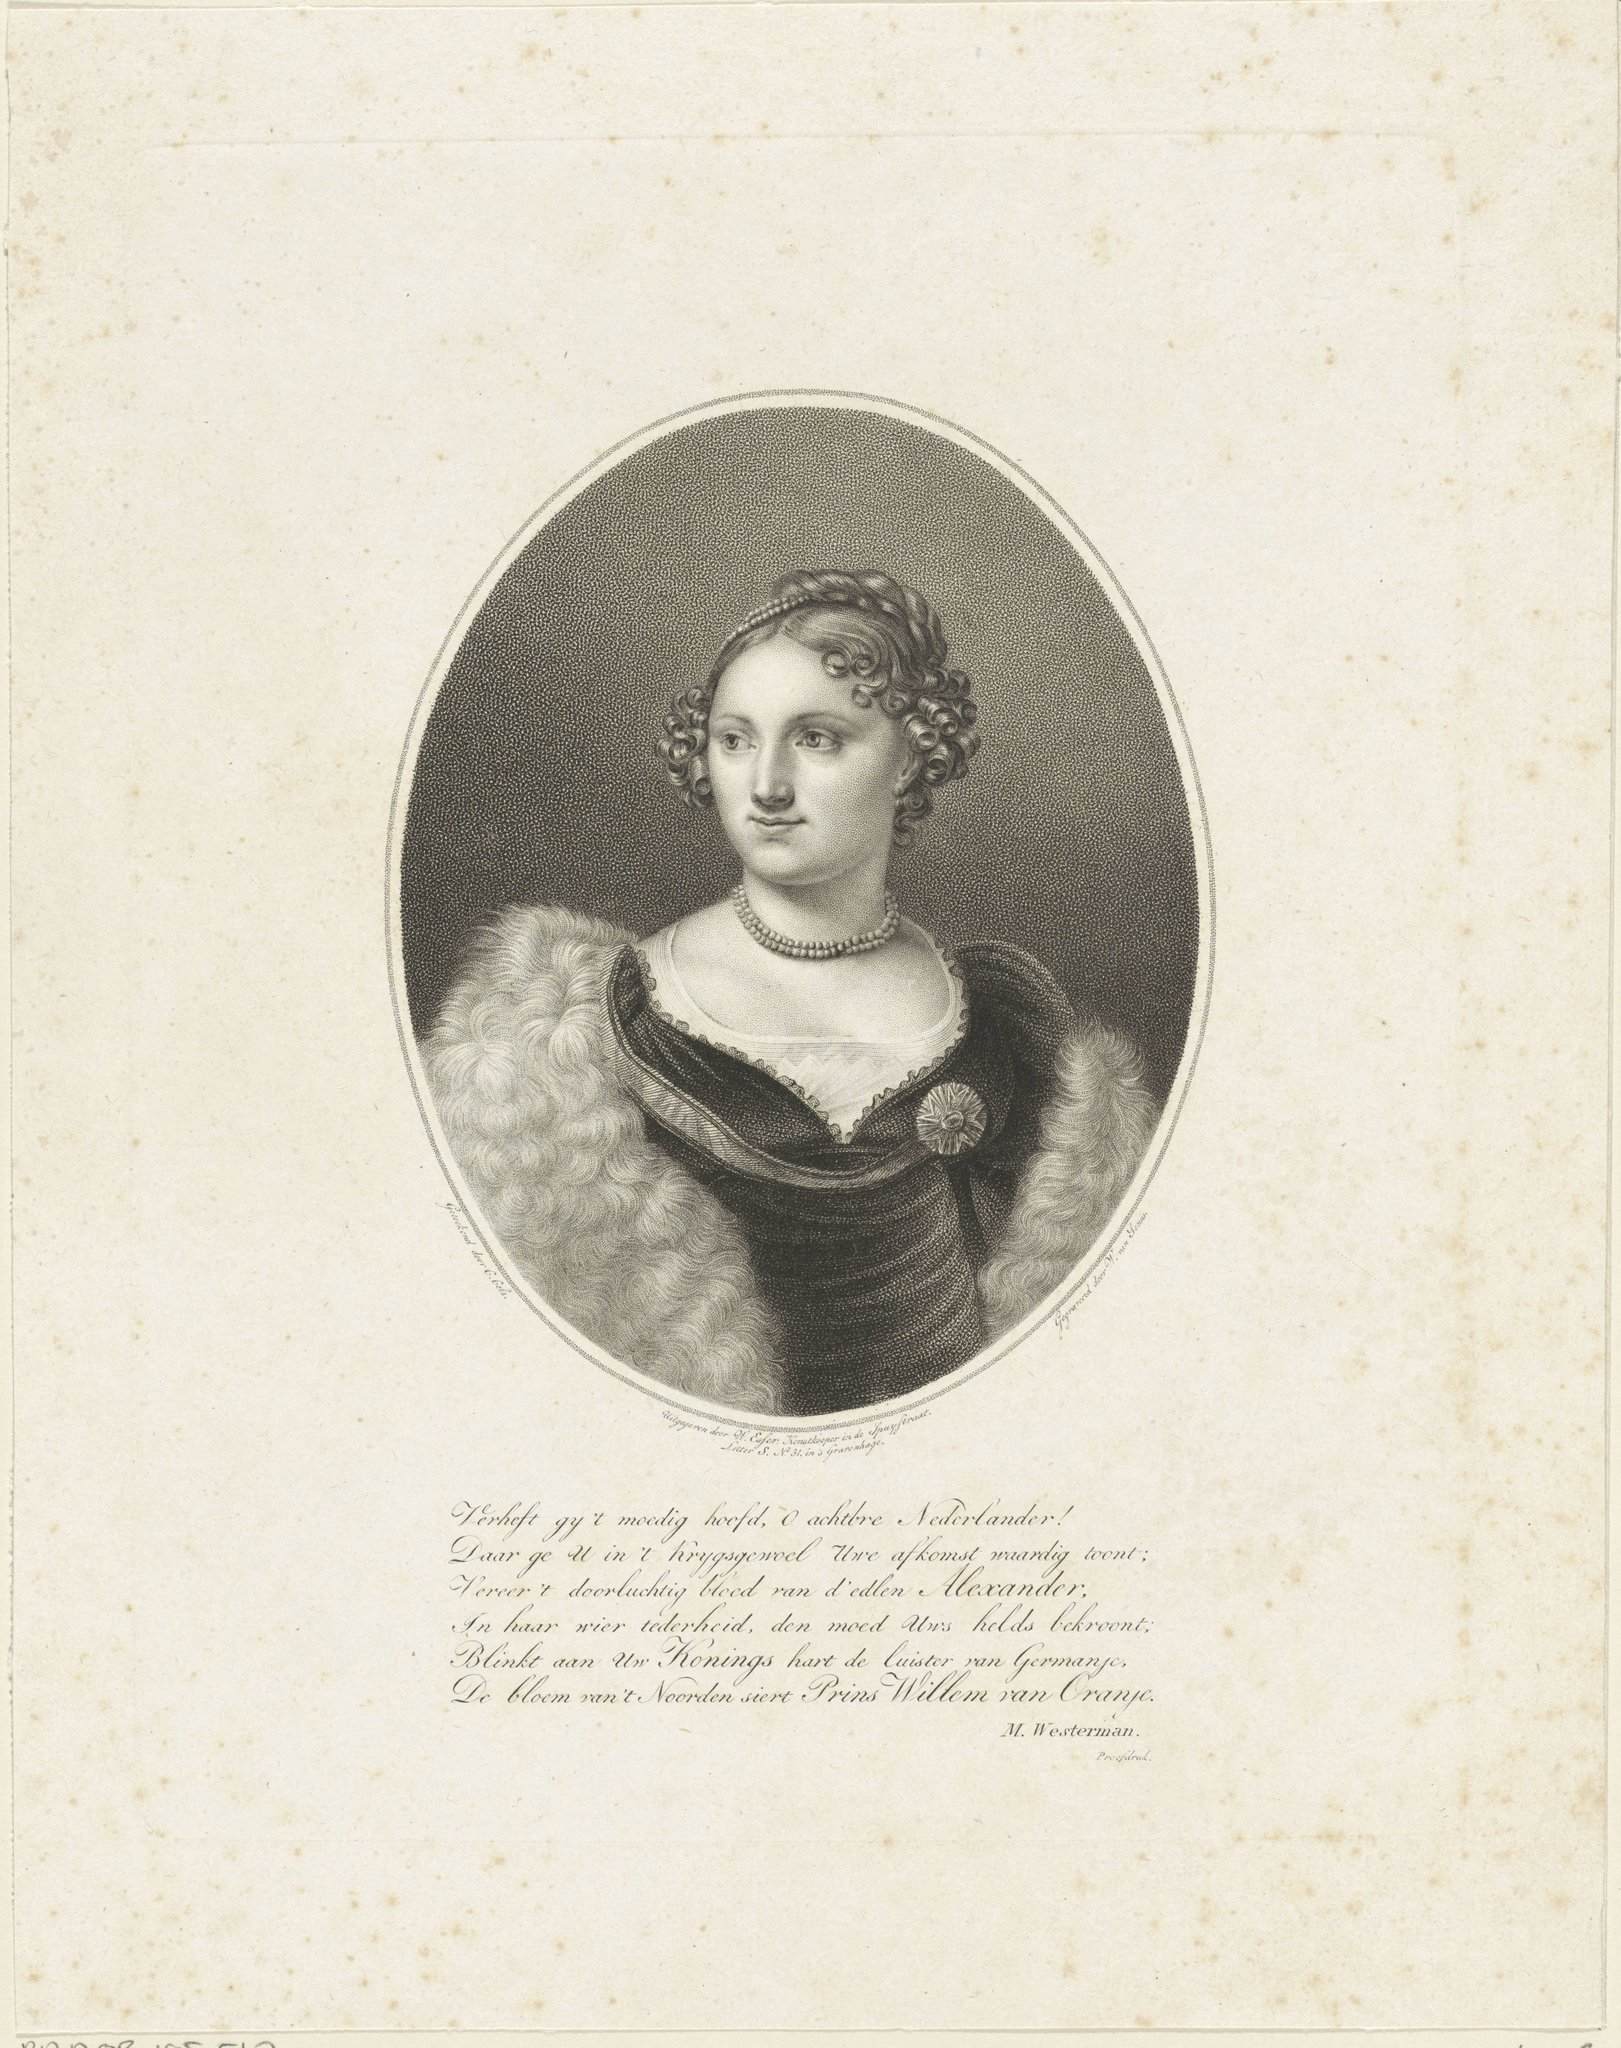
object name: print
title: Portret van Anna Paulowna Romanowa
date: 1816-1860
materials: paper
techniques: engraving, etching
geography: netherlands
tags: the hague, anna paulowna romanowa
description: Portret van Anna Paulowna in een ovaal. In de ondermarge zes regels Nederlandse tekst. Rechtsonder 'Proefdruk.'.